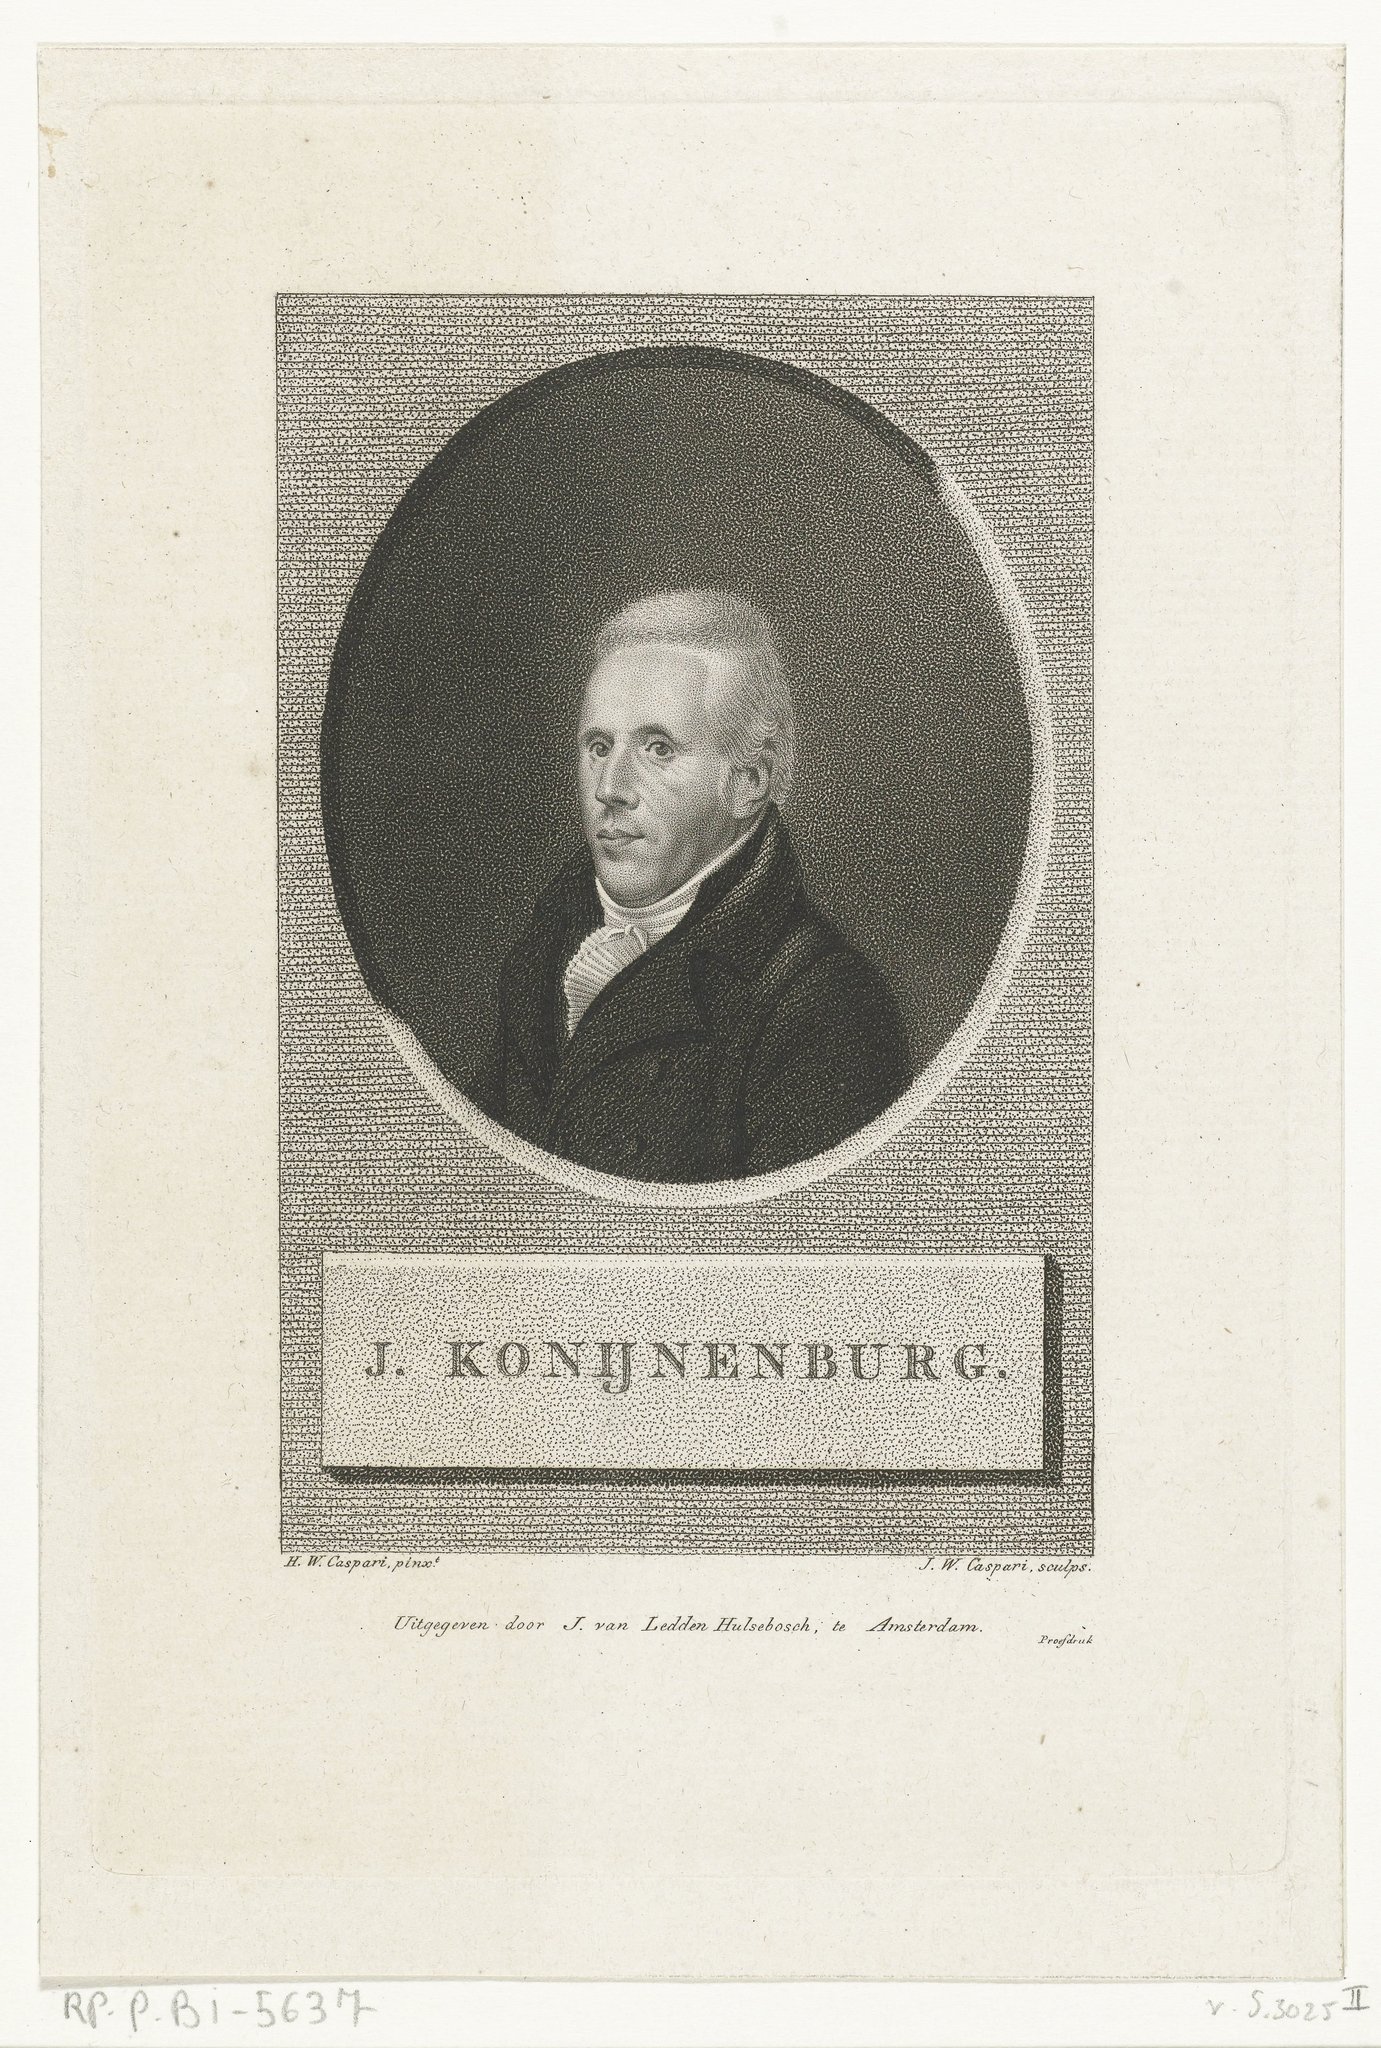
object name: print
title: Portret van Jan Konijnenburg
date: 1789-1822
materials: paper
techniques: etching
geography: amsterdam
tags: leiden, jan konijnenburg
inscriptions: collector's mark: Lugt 2228, caption: ‘Proefdruk’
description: Rond portret van Jan Konijnenburg, predikant en hoogleraar aan het Remonstrants Seminarium in Amsterdam. Buste naar links. Konijnenburg heeft een zwarte jas aan met een hoge kraag. De prent heeft een onderschrift met naam geportretteerde.